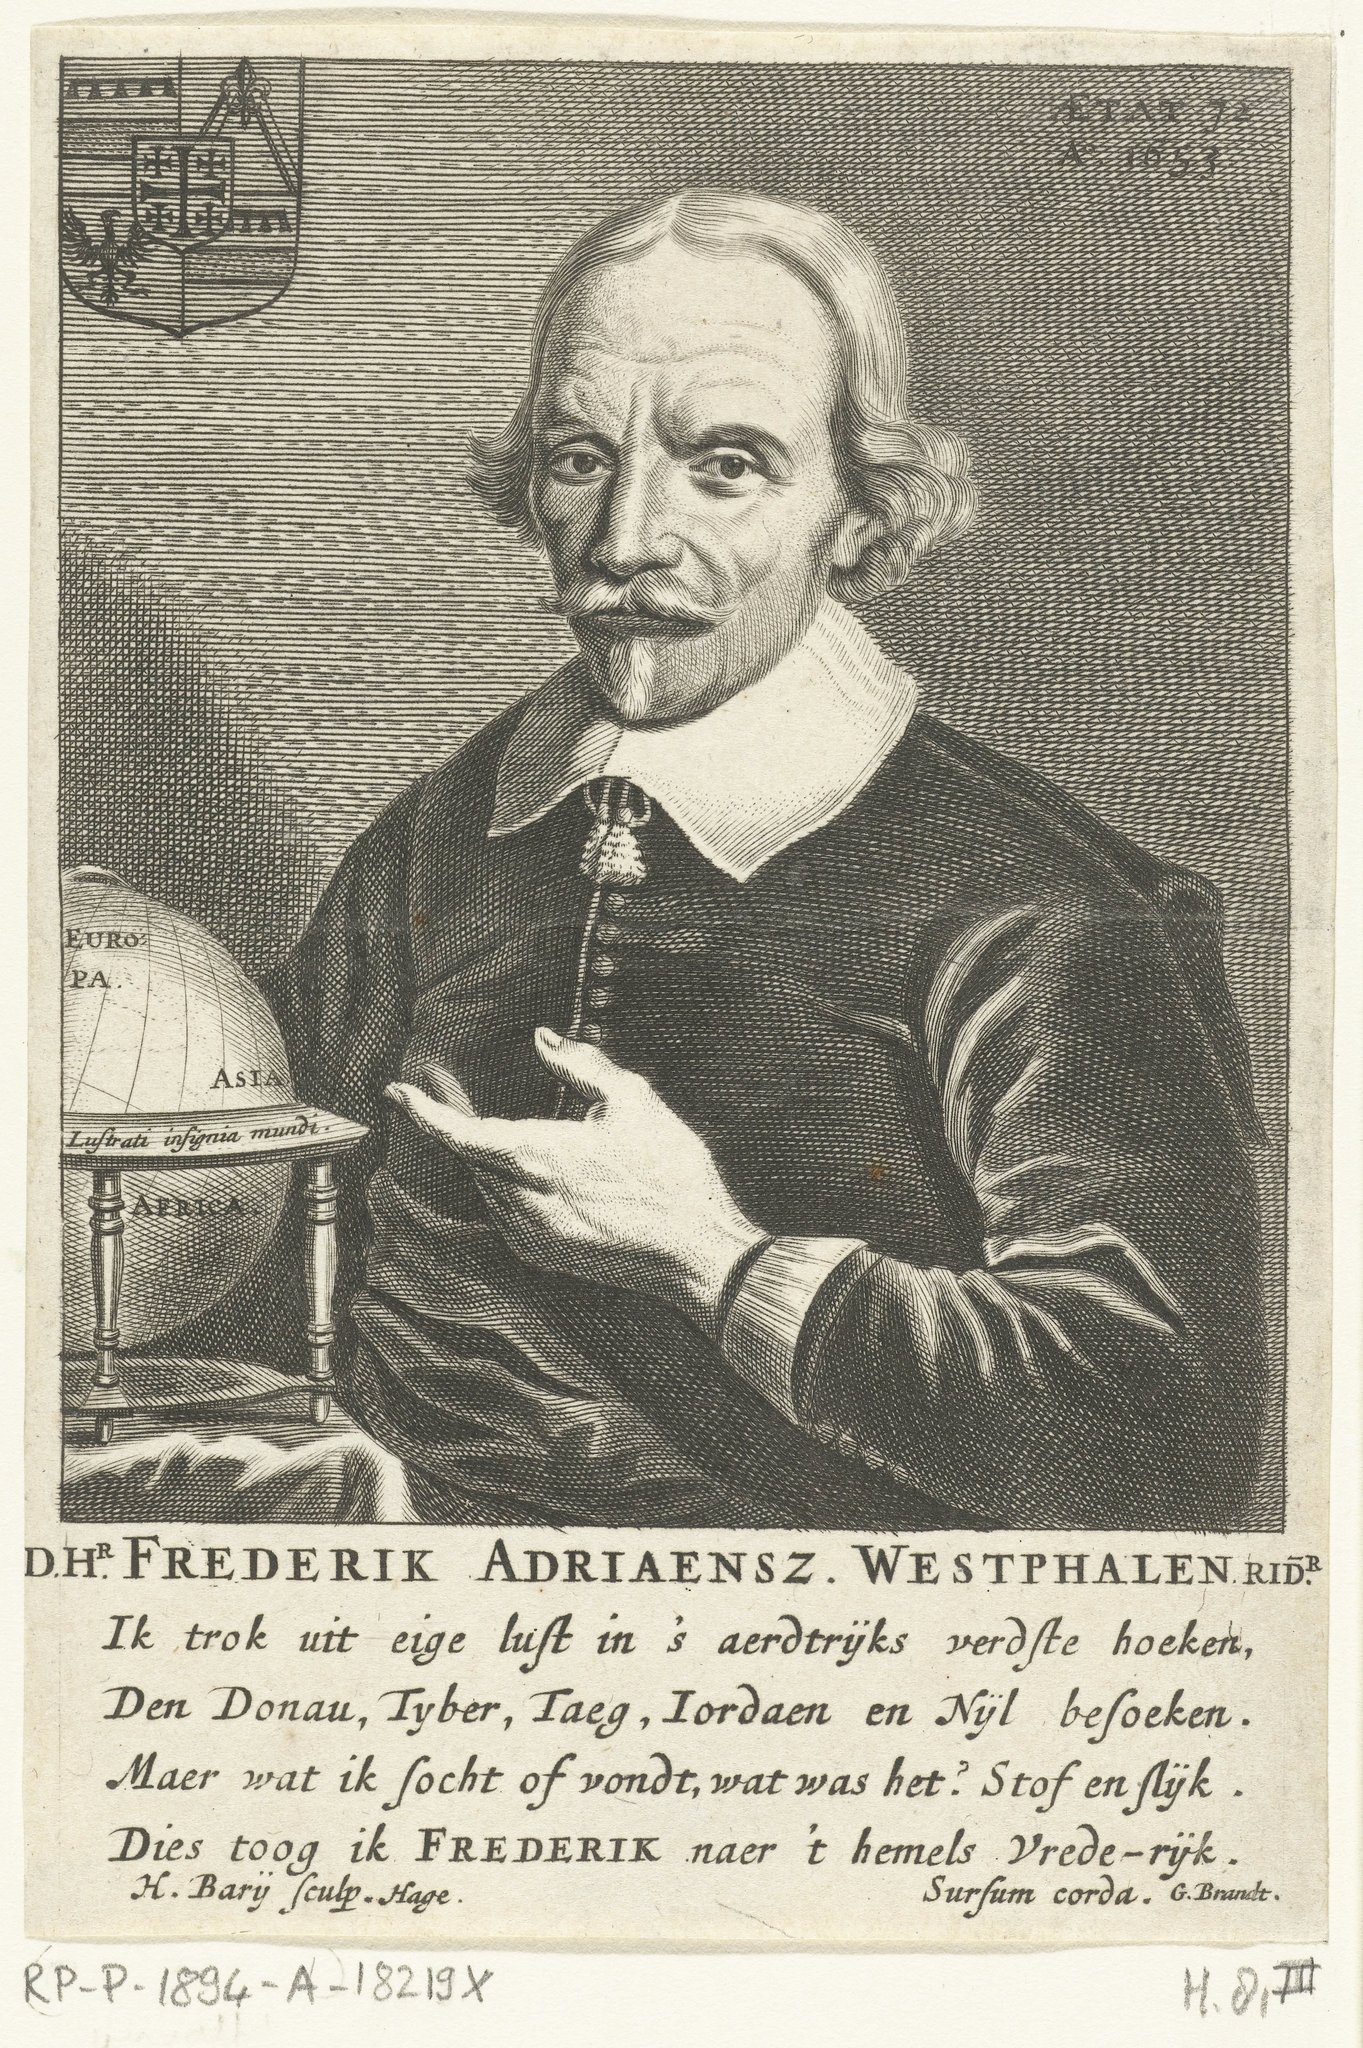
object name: print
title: Portret van Frederik Adriaensz. Westphalen op 72-jarige leeftijd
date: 1657-1707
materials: paper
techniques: engraving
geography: the hague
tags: enkhuizen, traveler, globe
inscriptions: collector's mark: Lugt 2228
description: Portret van Frederik Adriaensz. Westphalen op 72-jarige leeftijd, naast hem een globe. In de linker bovenhoek zijn wapen. Onder het portret een vers van vier regels in het Nederlands door G. Brandt getekend: Sursum Corda.